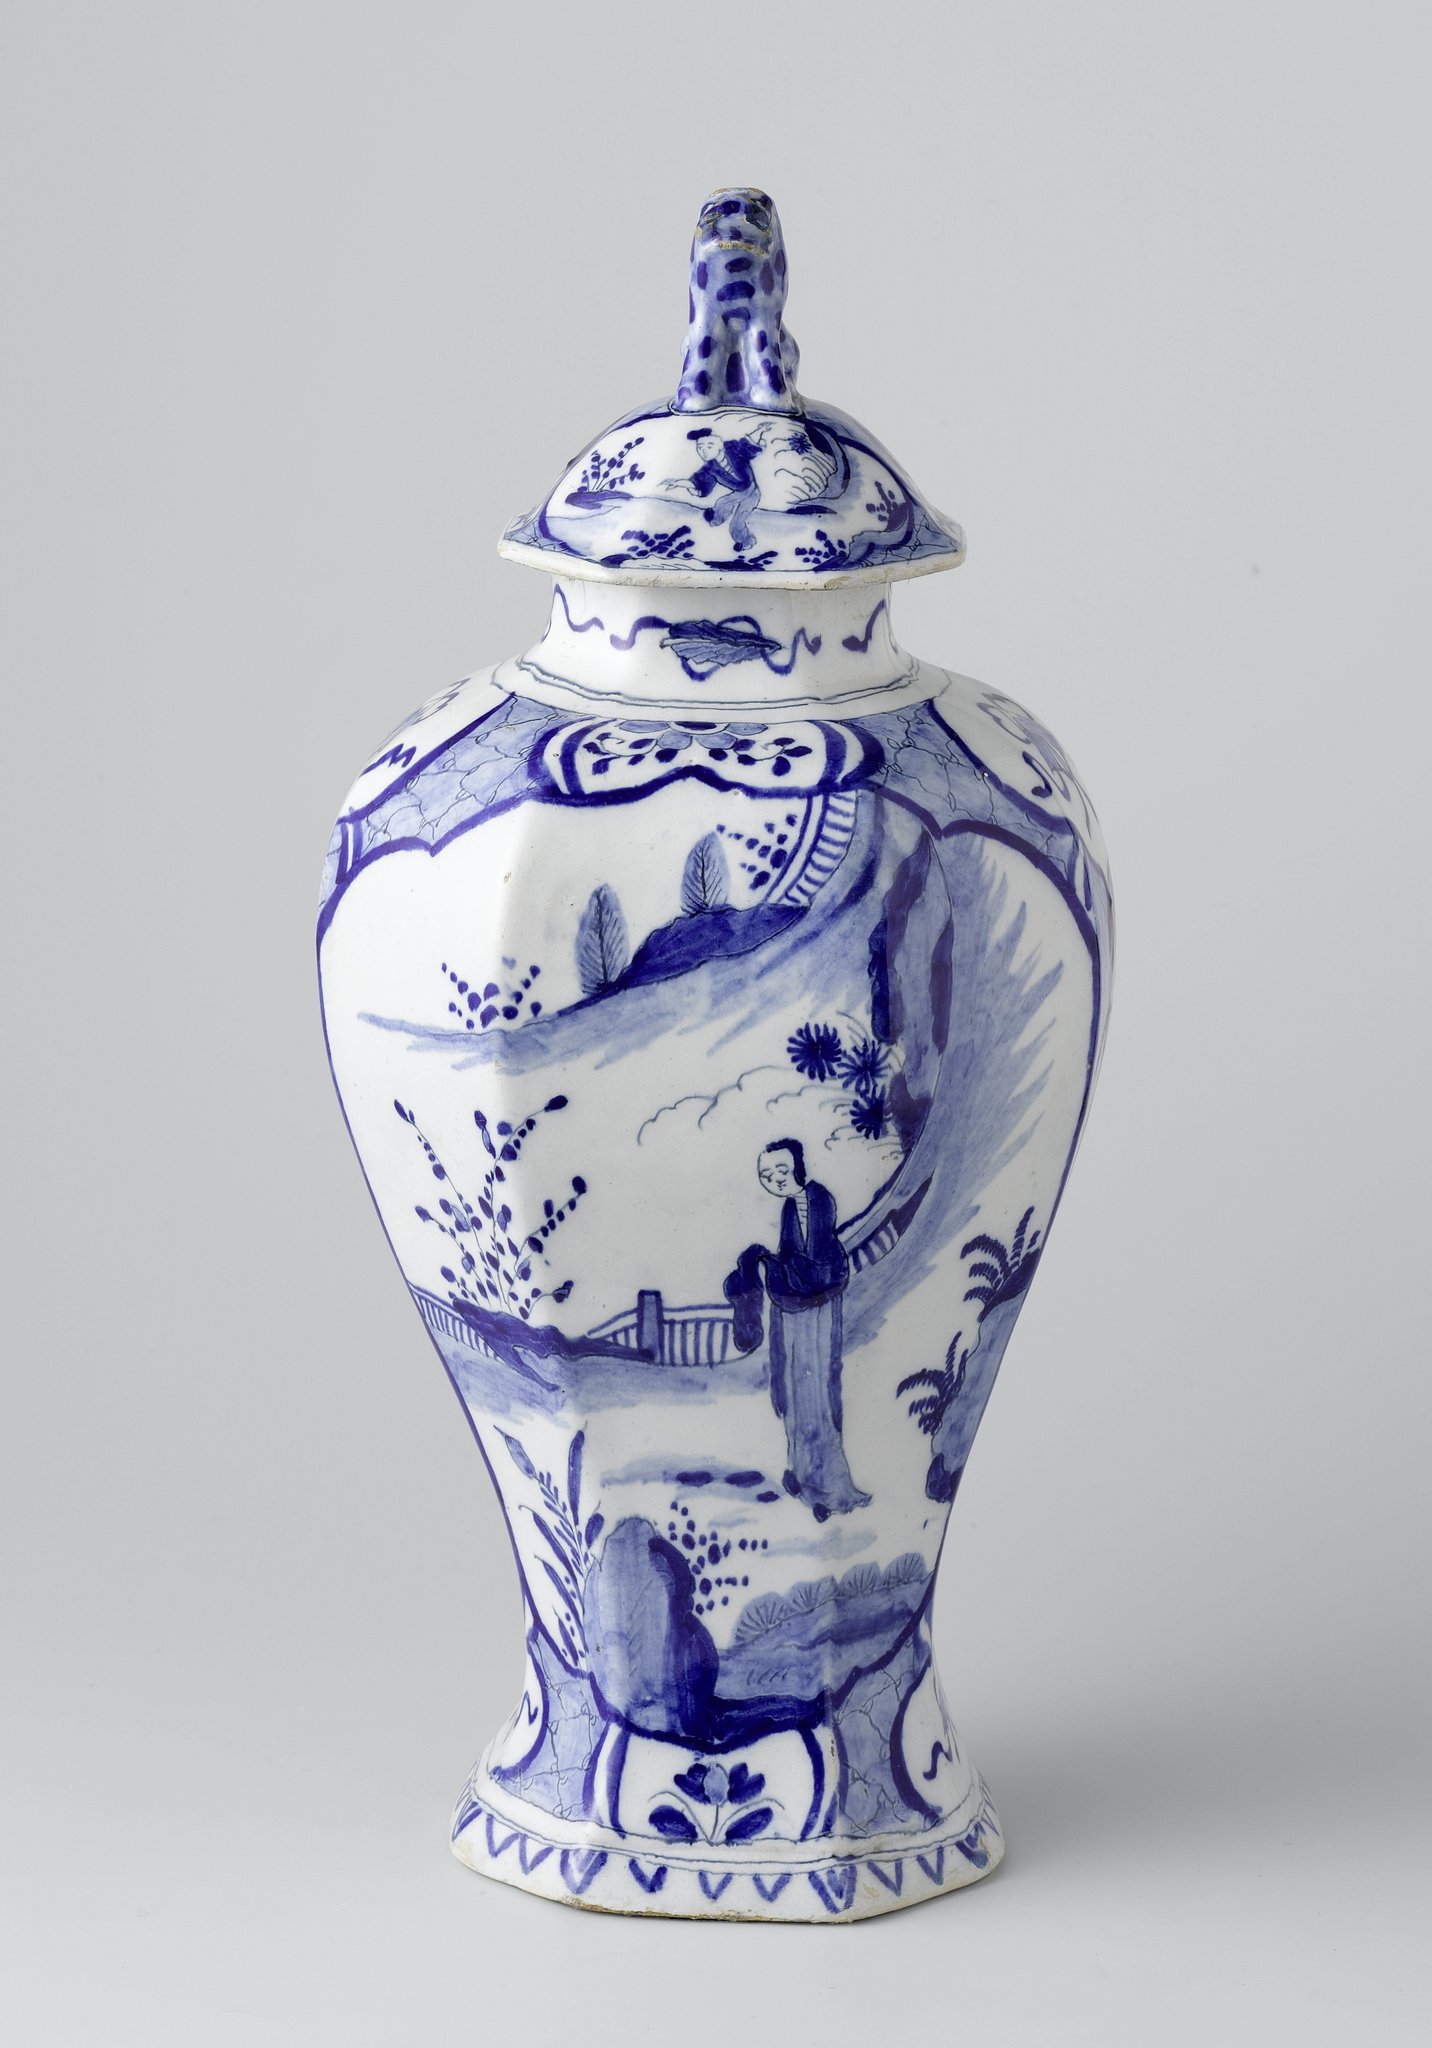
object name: kaststel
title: Garniture with three vases and two beaker vases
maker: zacharias dextra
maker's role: plateelbakker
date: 1740-1760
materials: earthenware, glaze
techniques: painted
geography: delft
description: Garnitures were extremely popular decorative elements in 18th-century Dutch interiors, where they were placed on cabinets or buffets. Although the forms of some garnitures evolved with the times, popular models, like this set with decorations inspired by Chinese porcelain, remained in production for many decades.